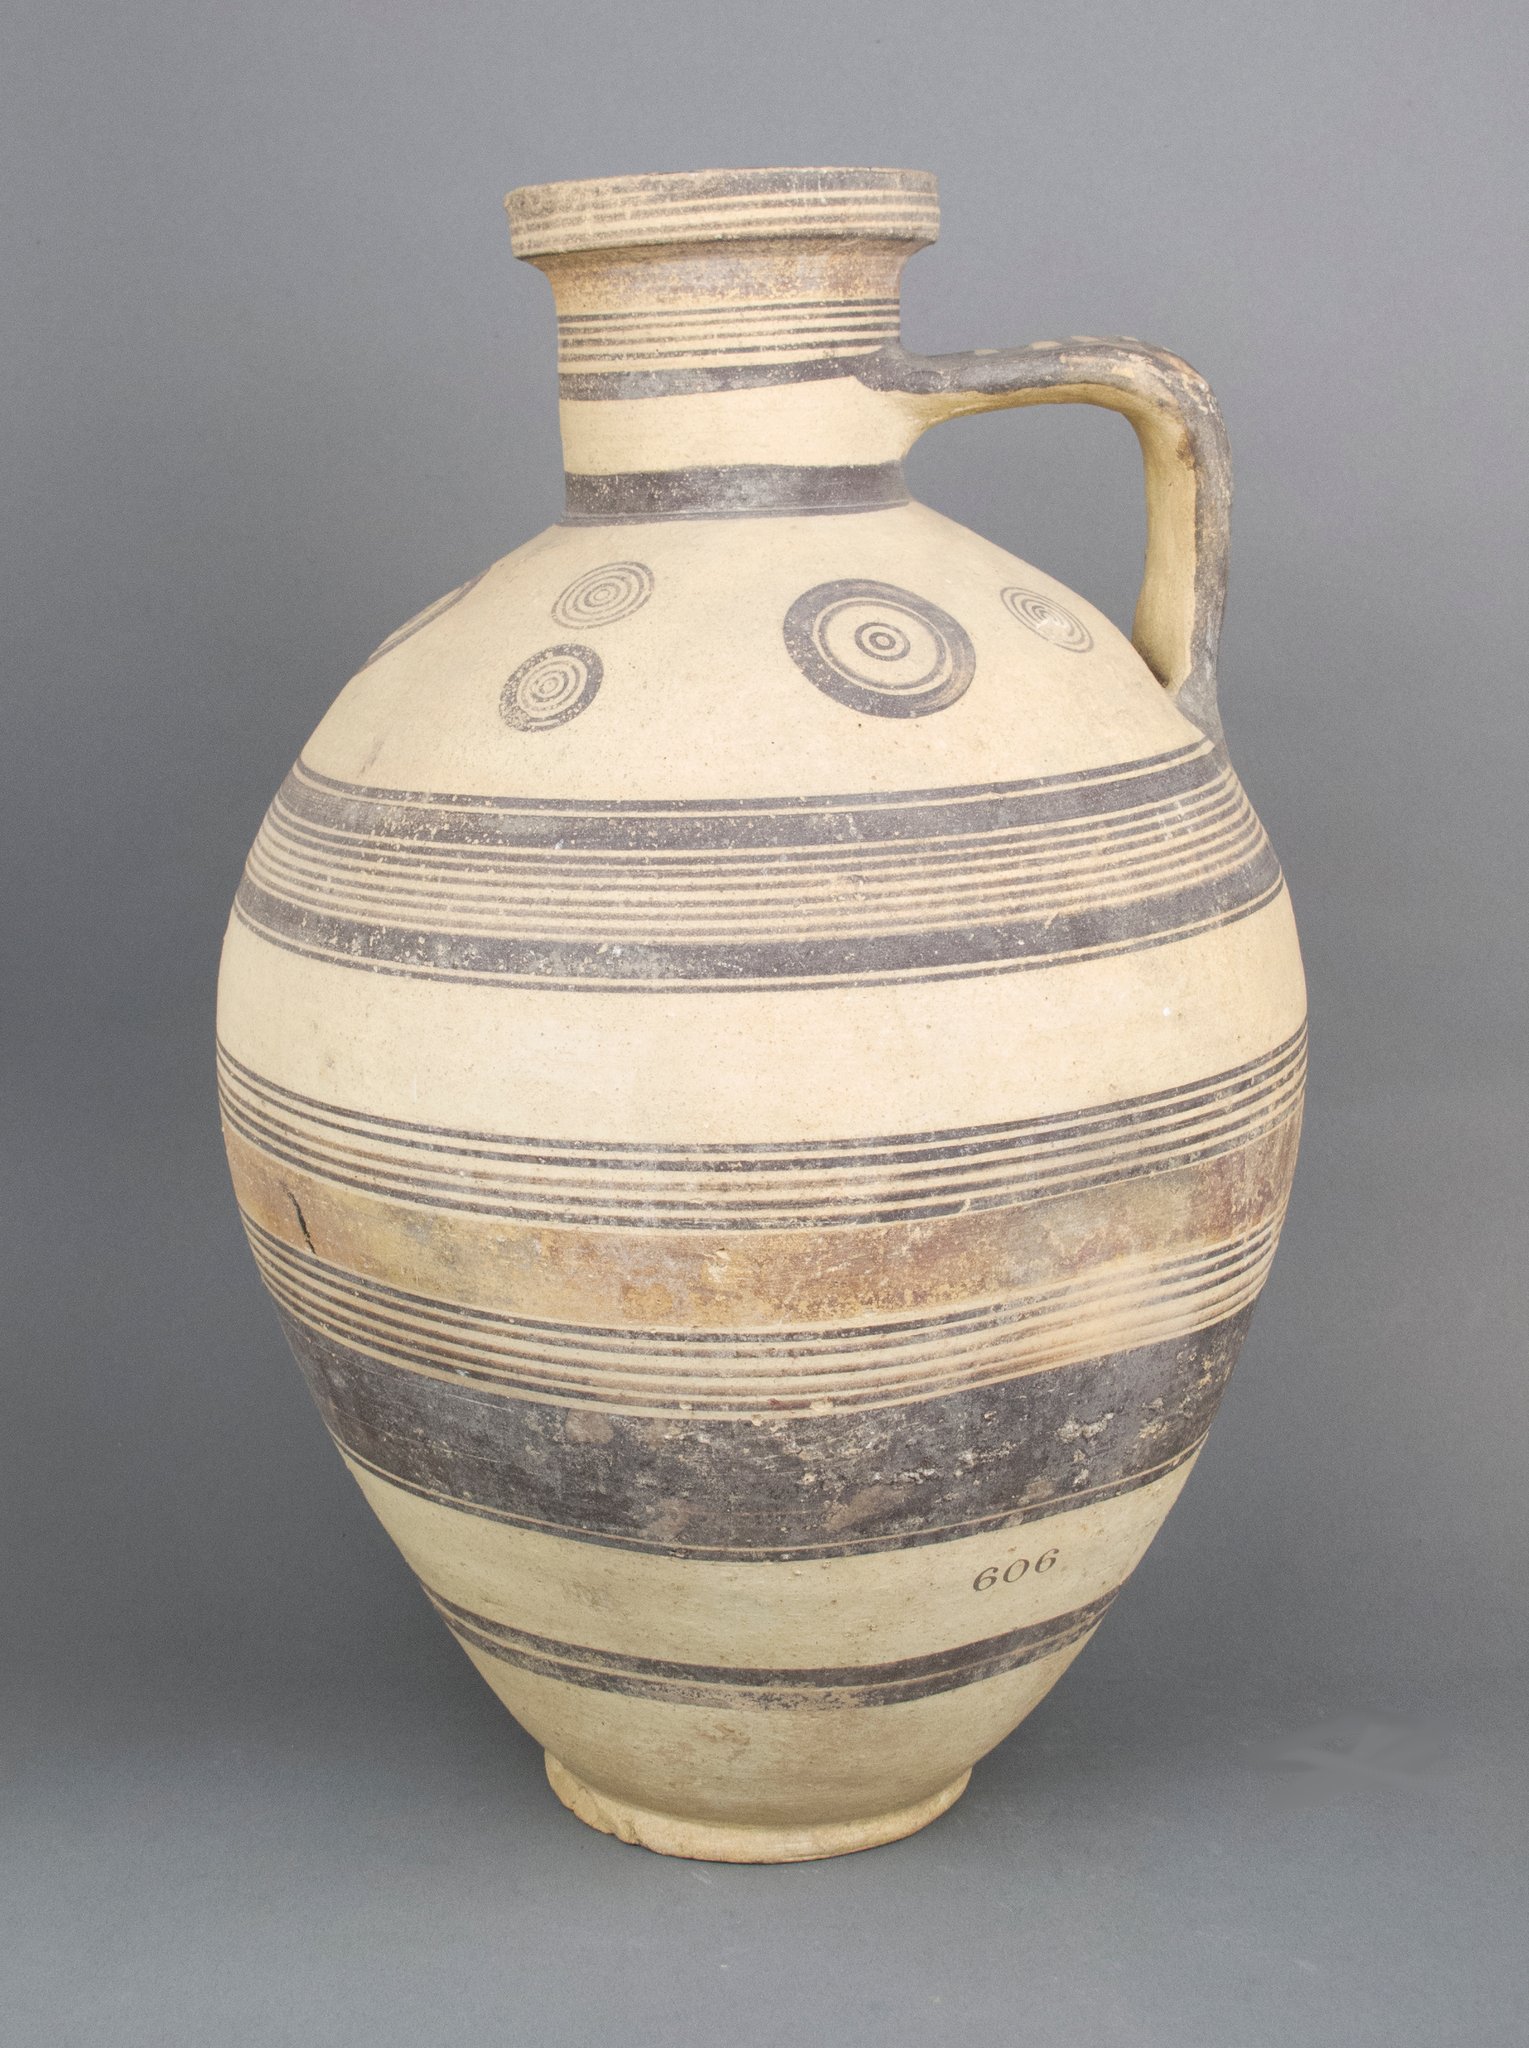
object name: jug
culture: cypriot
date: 480-400 BCE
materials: terracotta